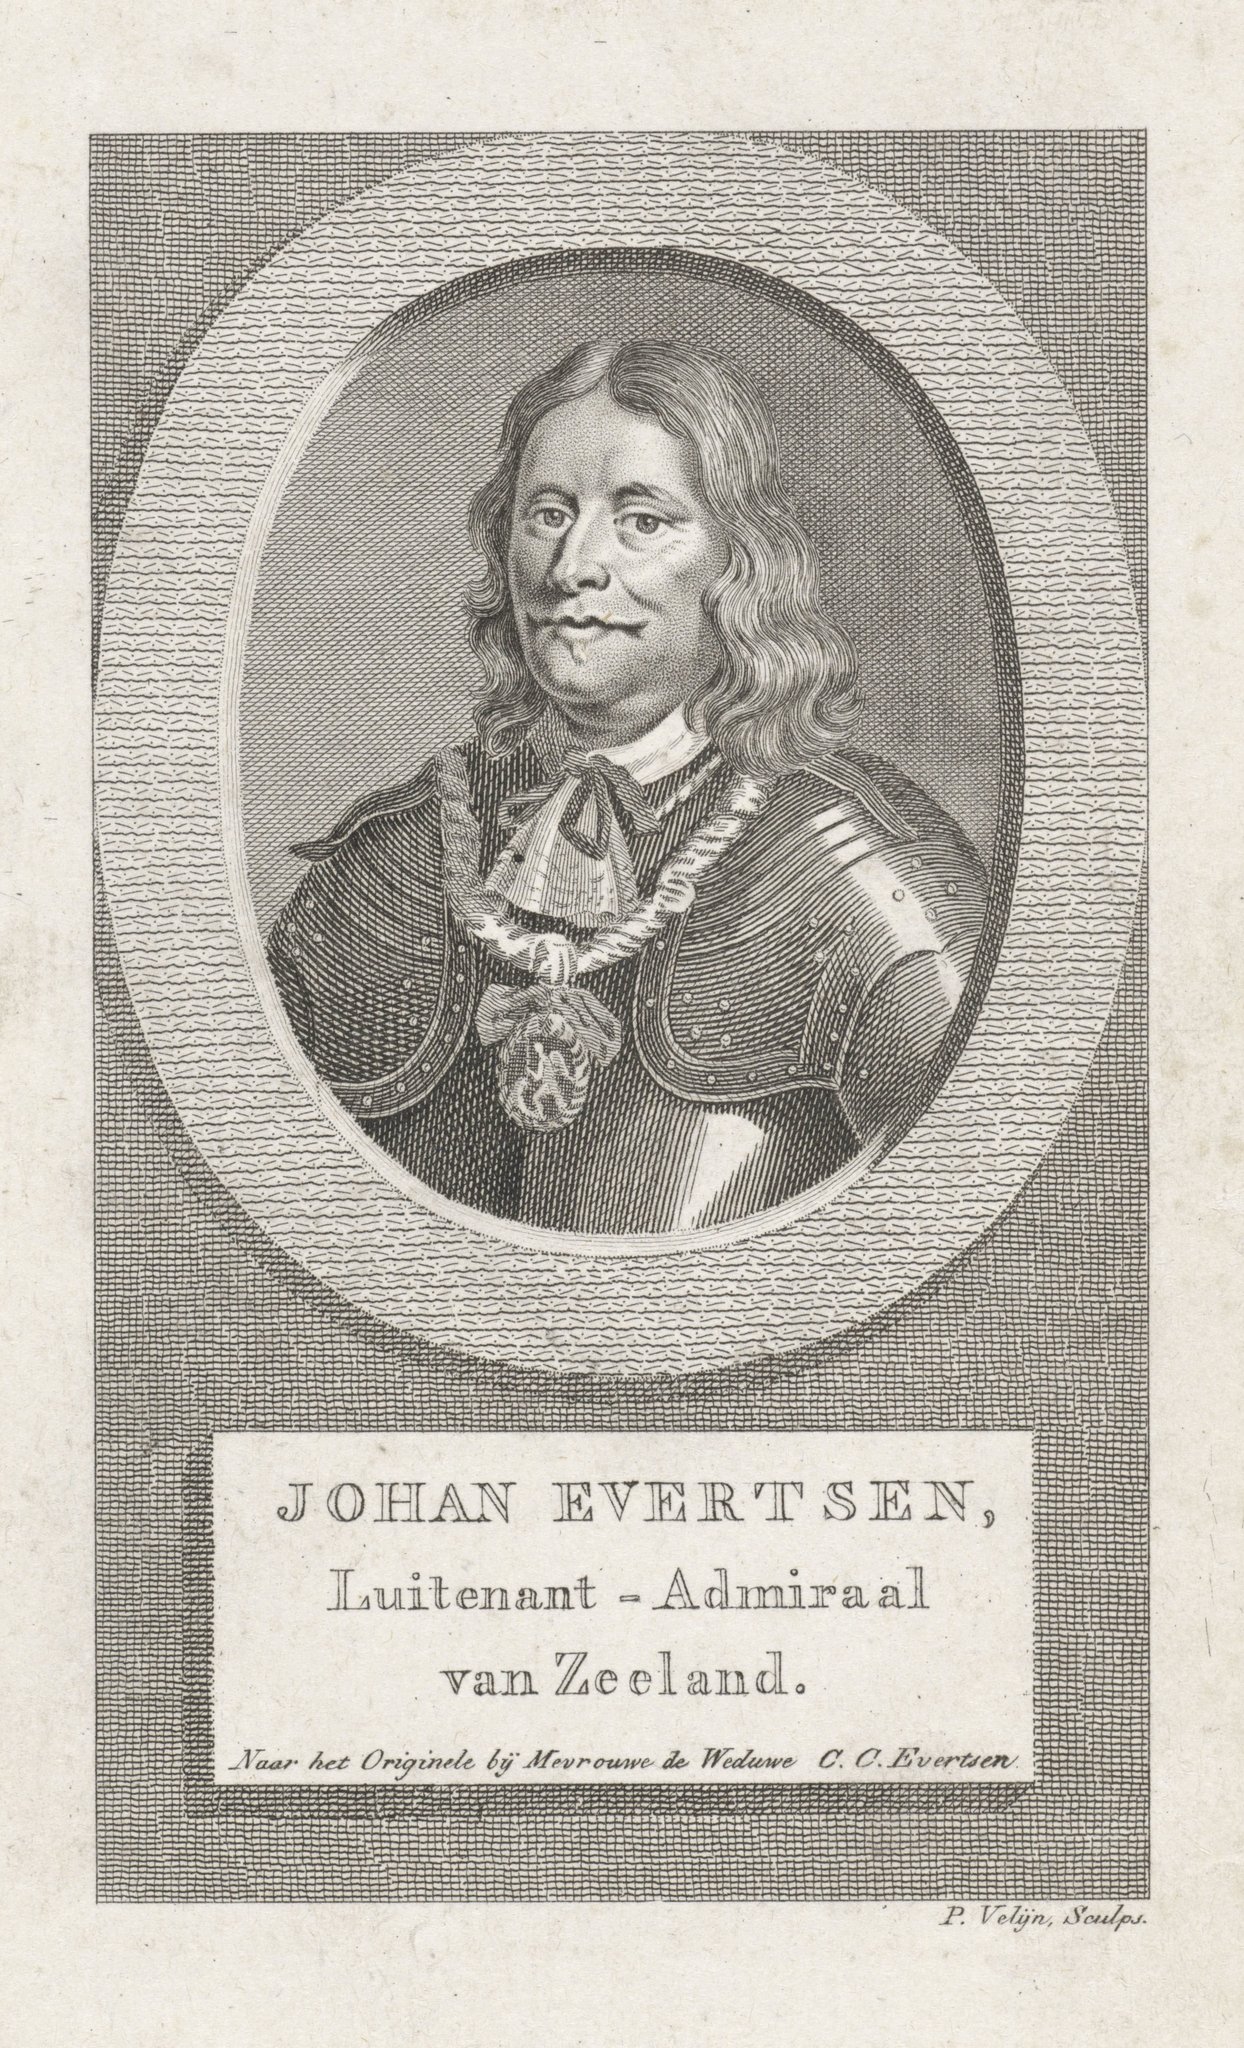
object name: print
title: Portret van Johan Evertsen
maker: philippus velijn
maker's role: print maker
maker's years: 1787-1836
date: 1797-1836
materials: paper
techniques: engraving, etching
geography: netherlands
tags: flushing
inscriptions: collector's mark: Lugt 2228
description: Portret van Johan Evertsen, luitenant-admiraal van Zeeland.